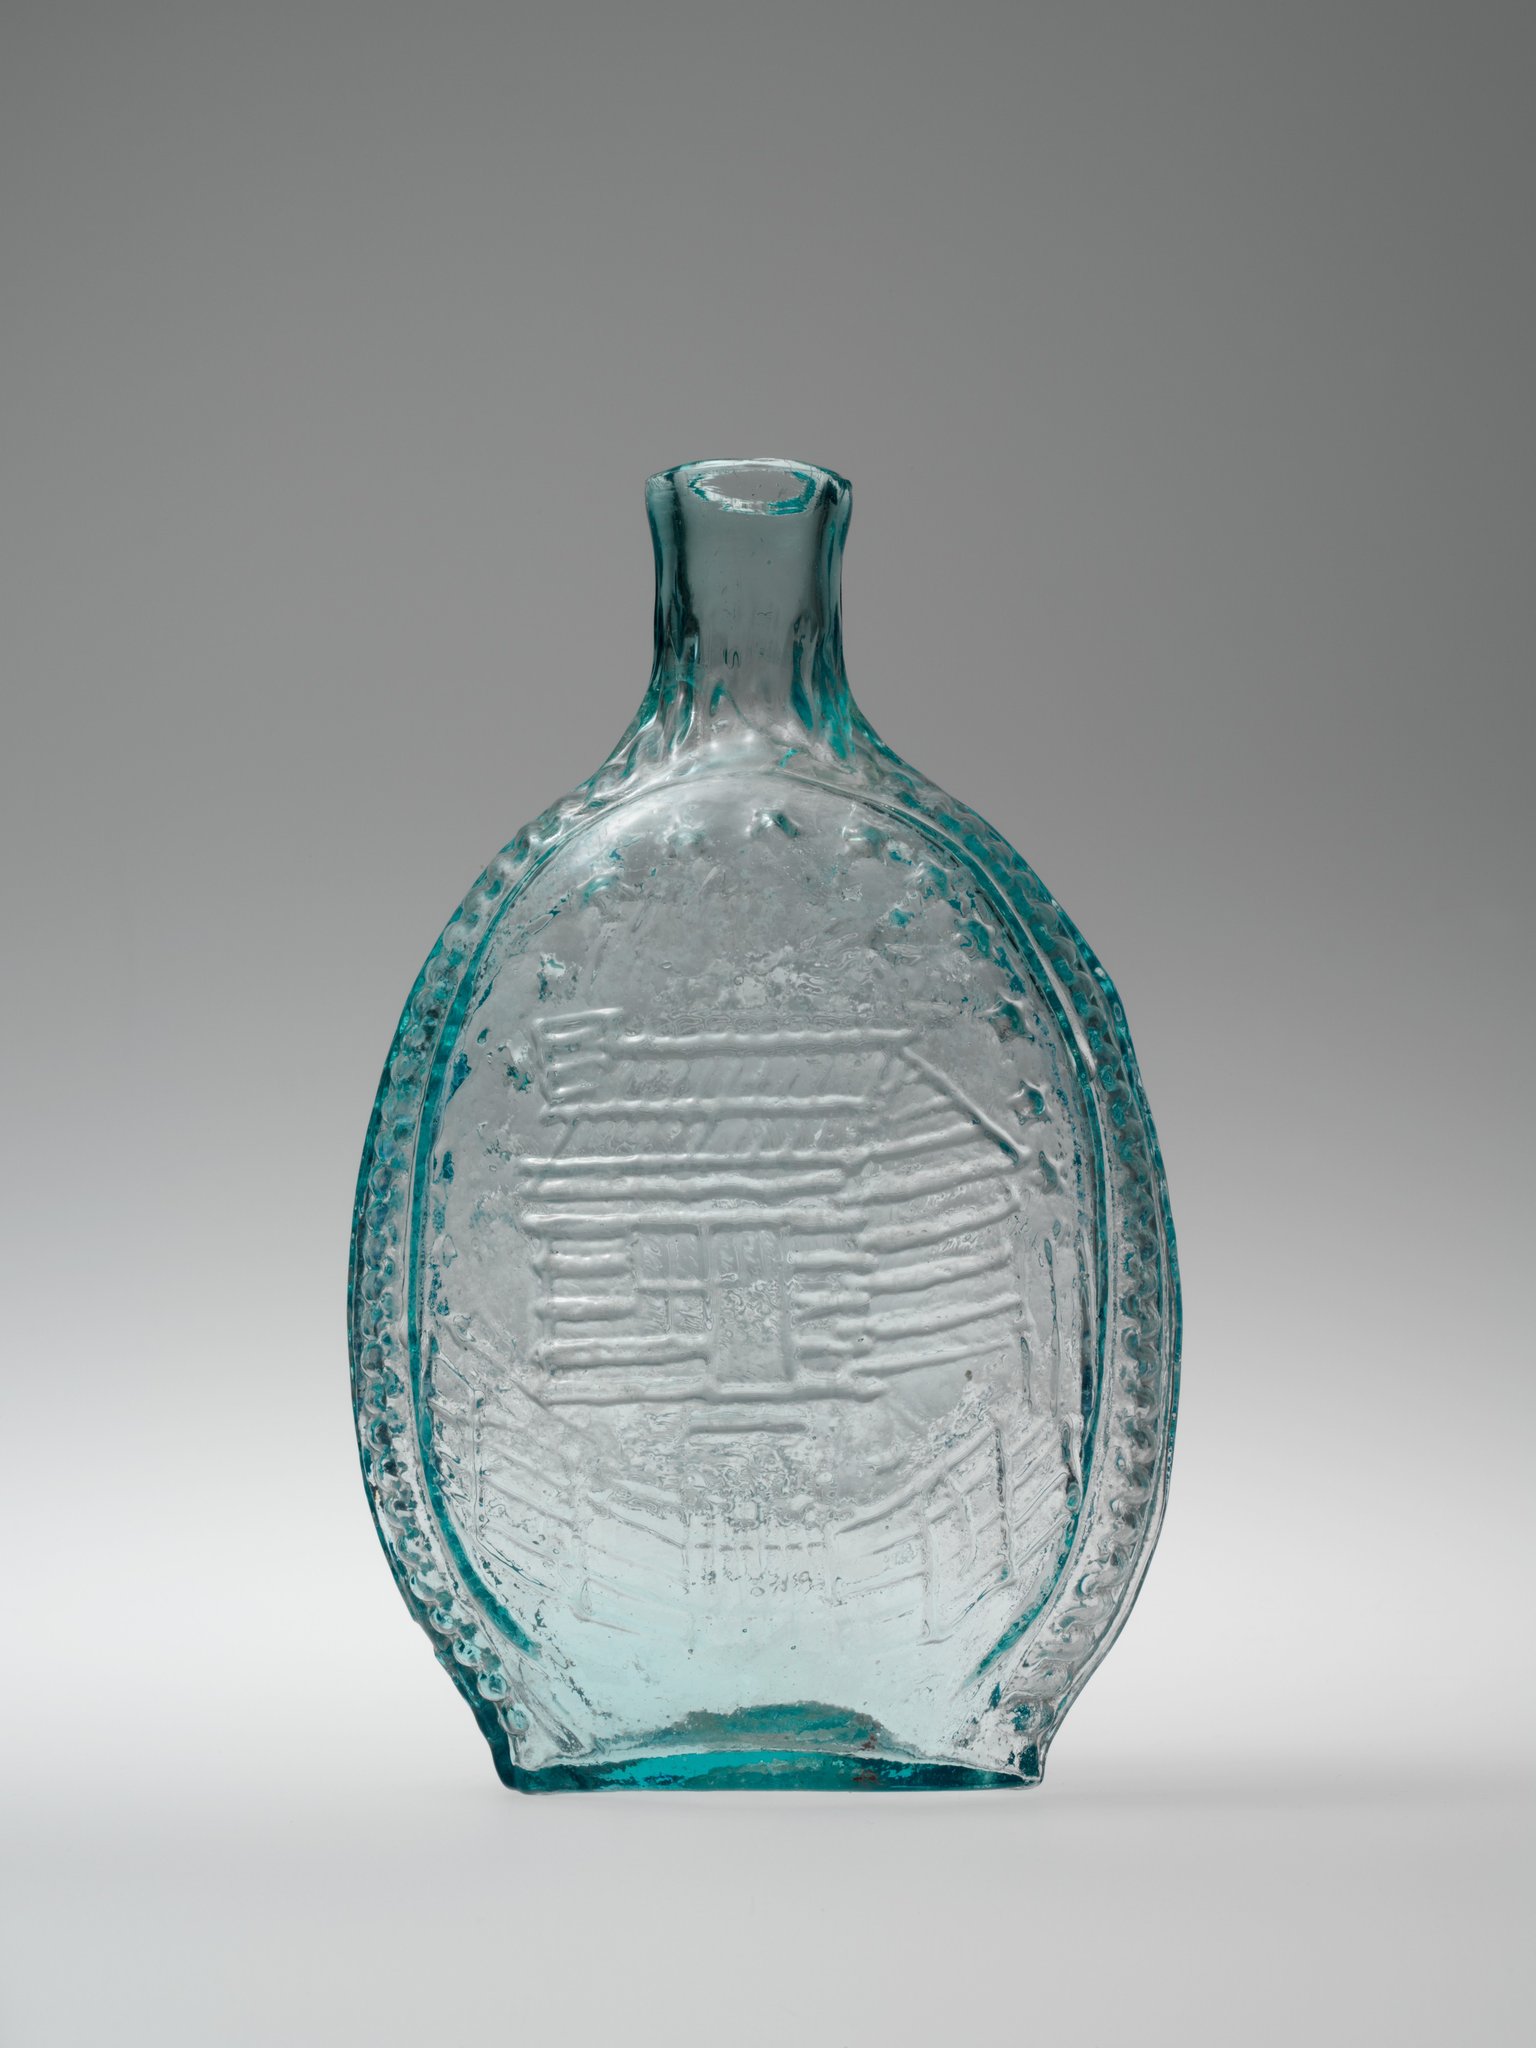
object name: flask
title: Figured flask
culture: american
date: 1840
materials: glass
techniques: glassblowing, molding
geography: united states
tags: houses